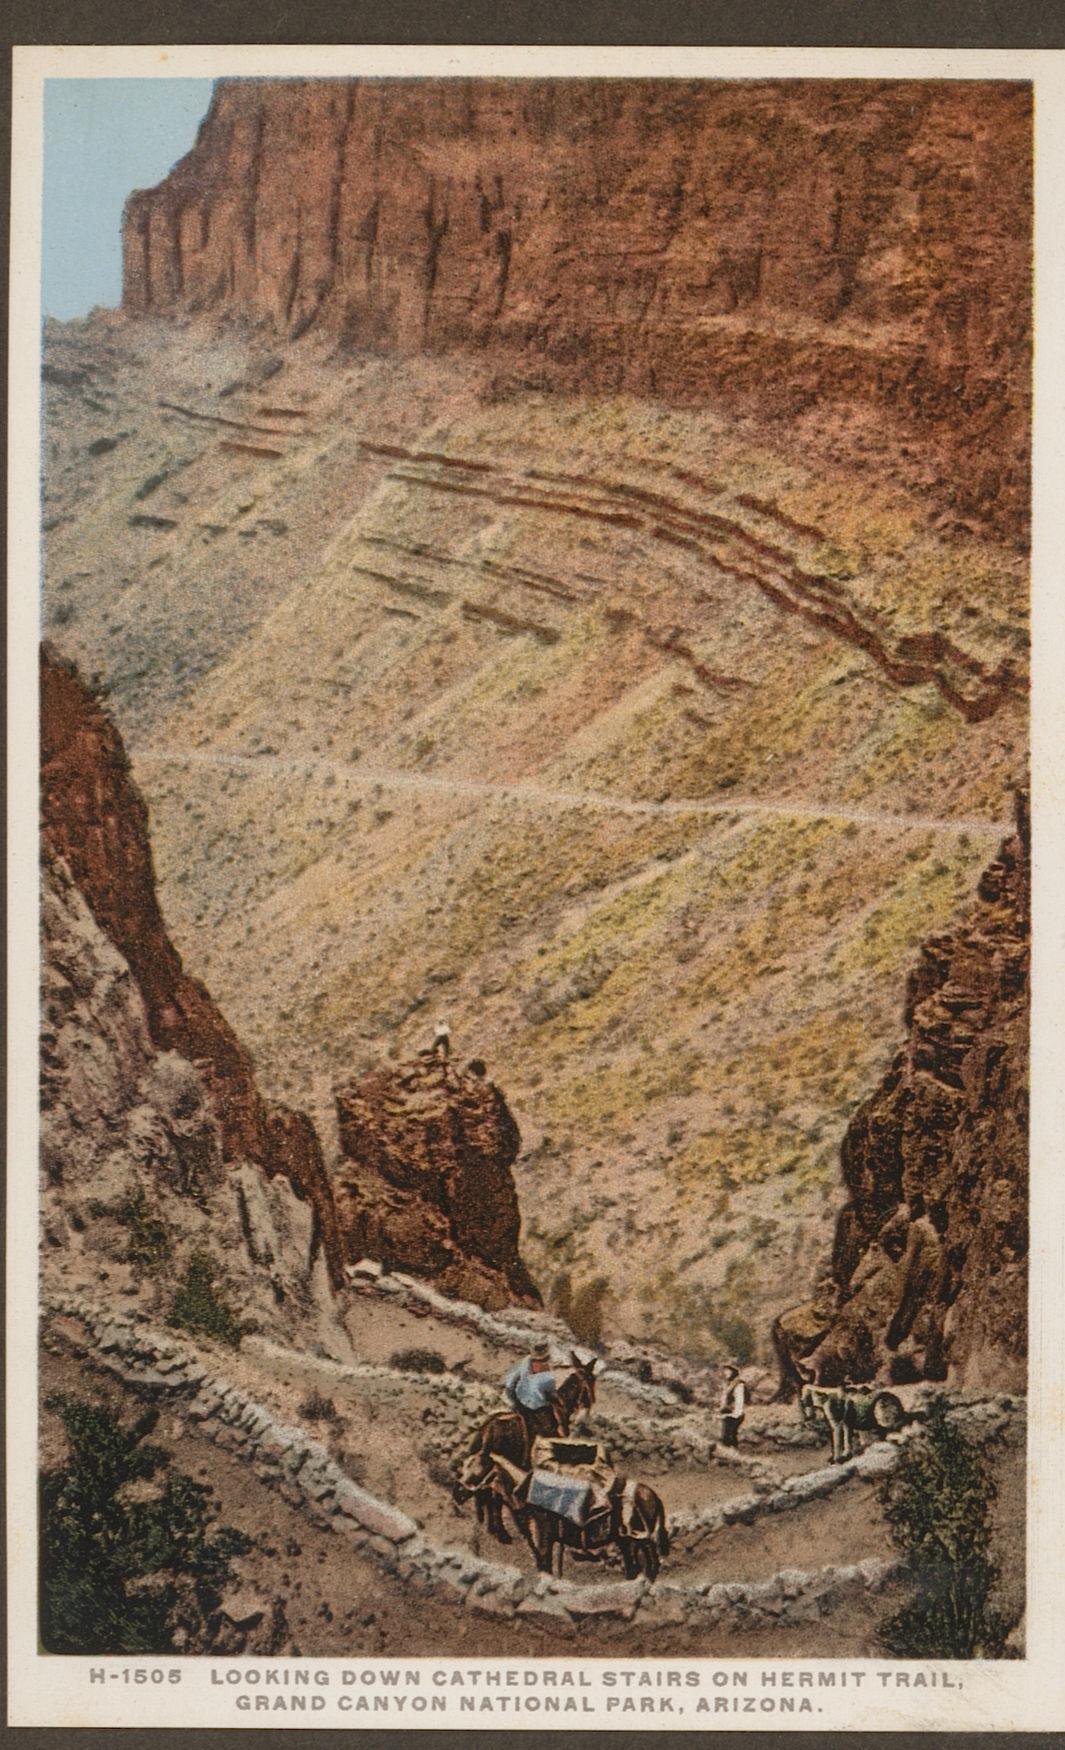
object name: album leaf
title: Looking down Cathedral Stairs on Hermit Trail, Grand Canyon National Park, Arizona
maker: Anonymous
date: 1928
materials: paper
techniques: four-color autotype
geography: grand canyon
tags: river, ravine, chasm, abyss, canyon, horse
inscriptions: annotation: ‘Grand Canyon’, number: ‘H - 1505’